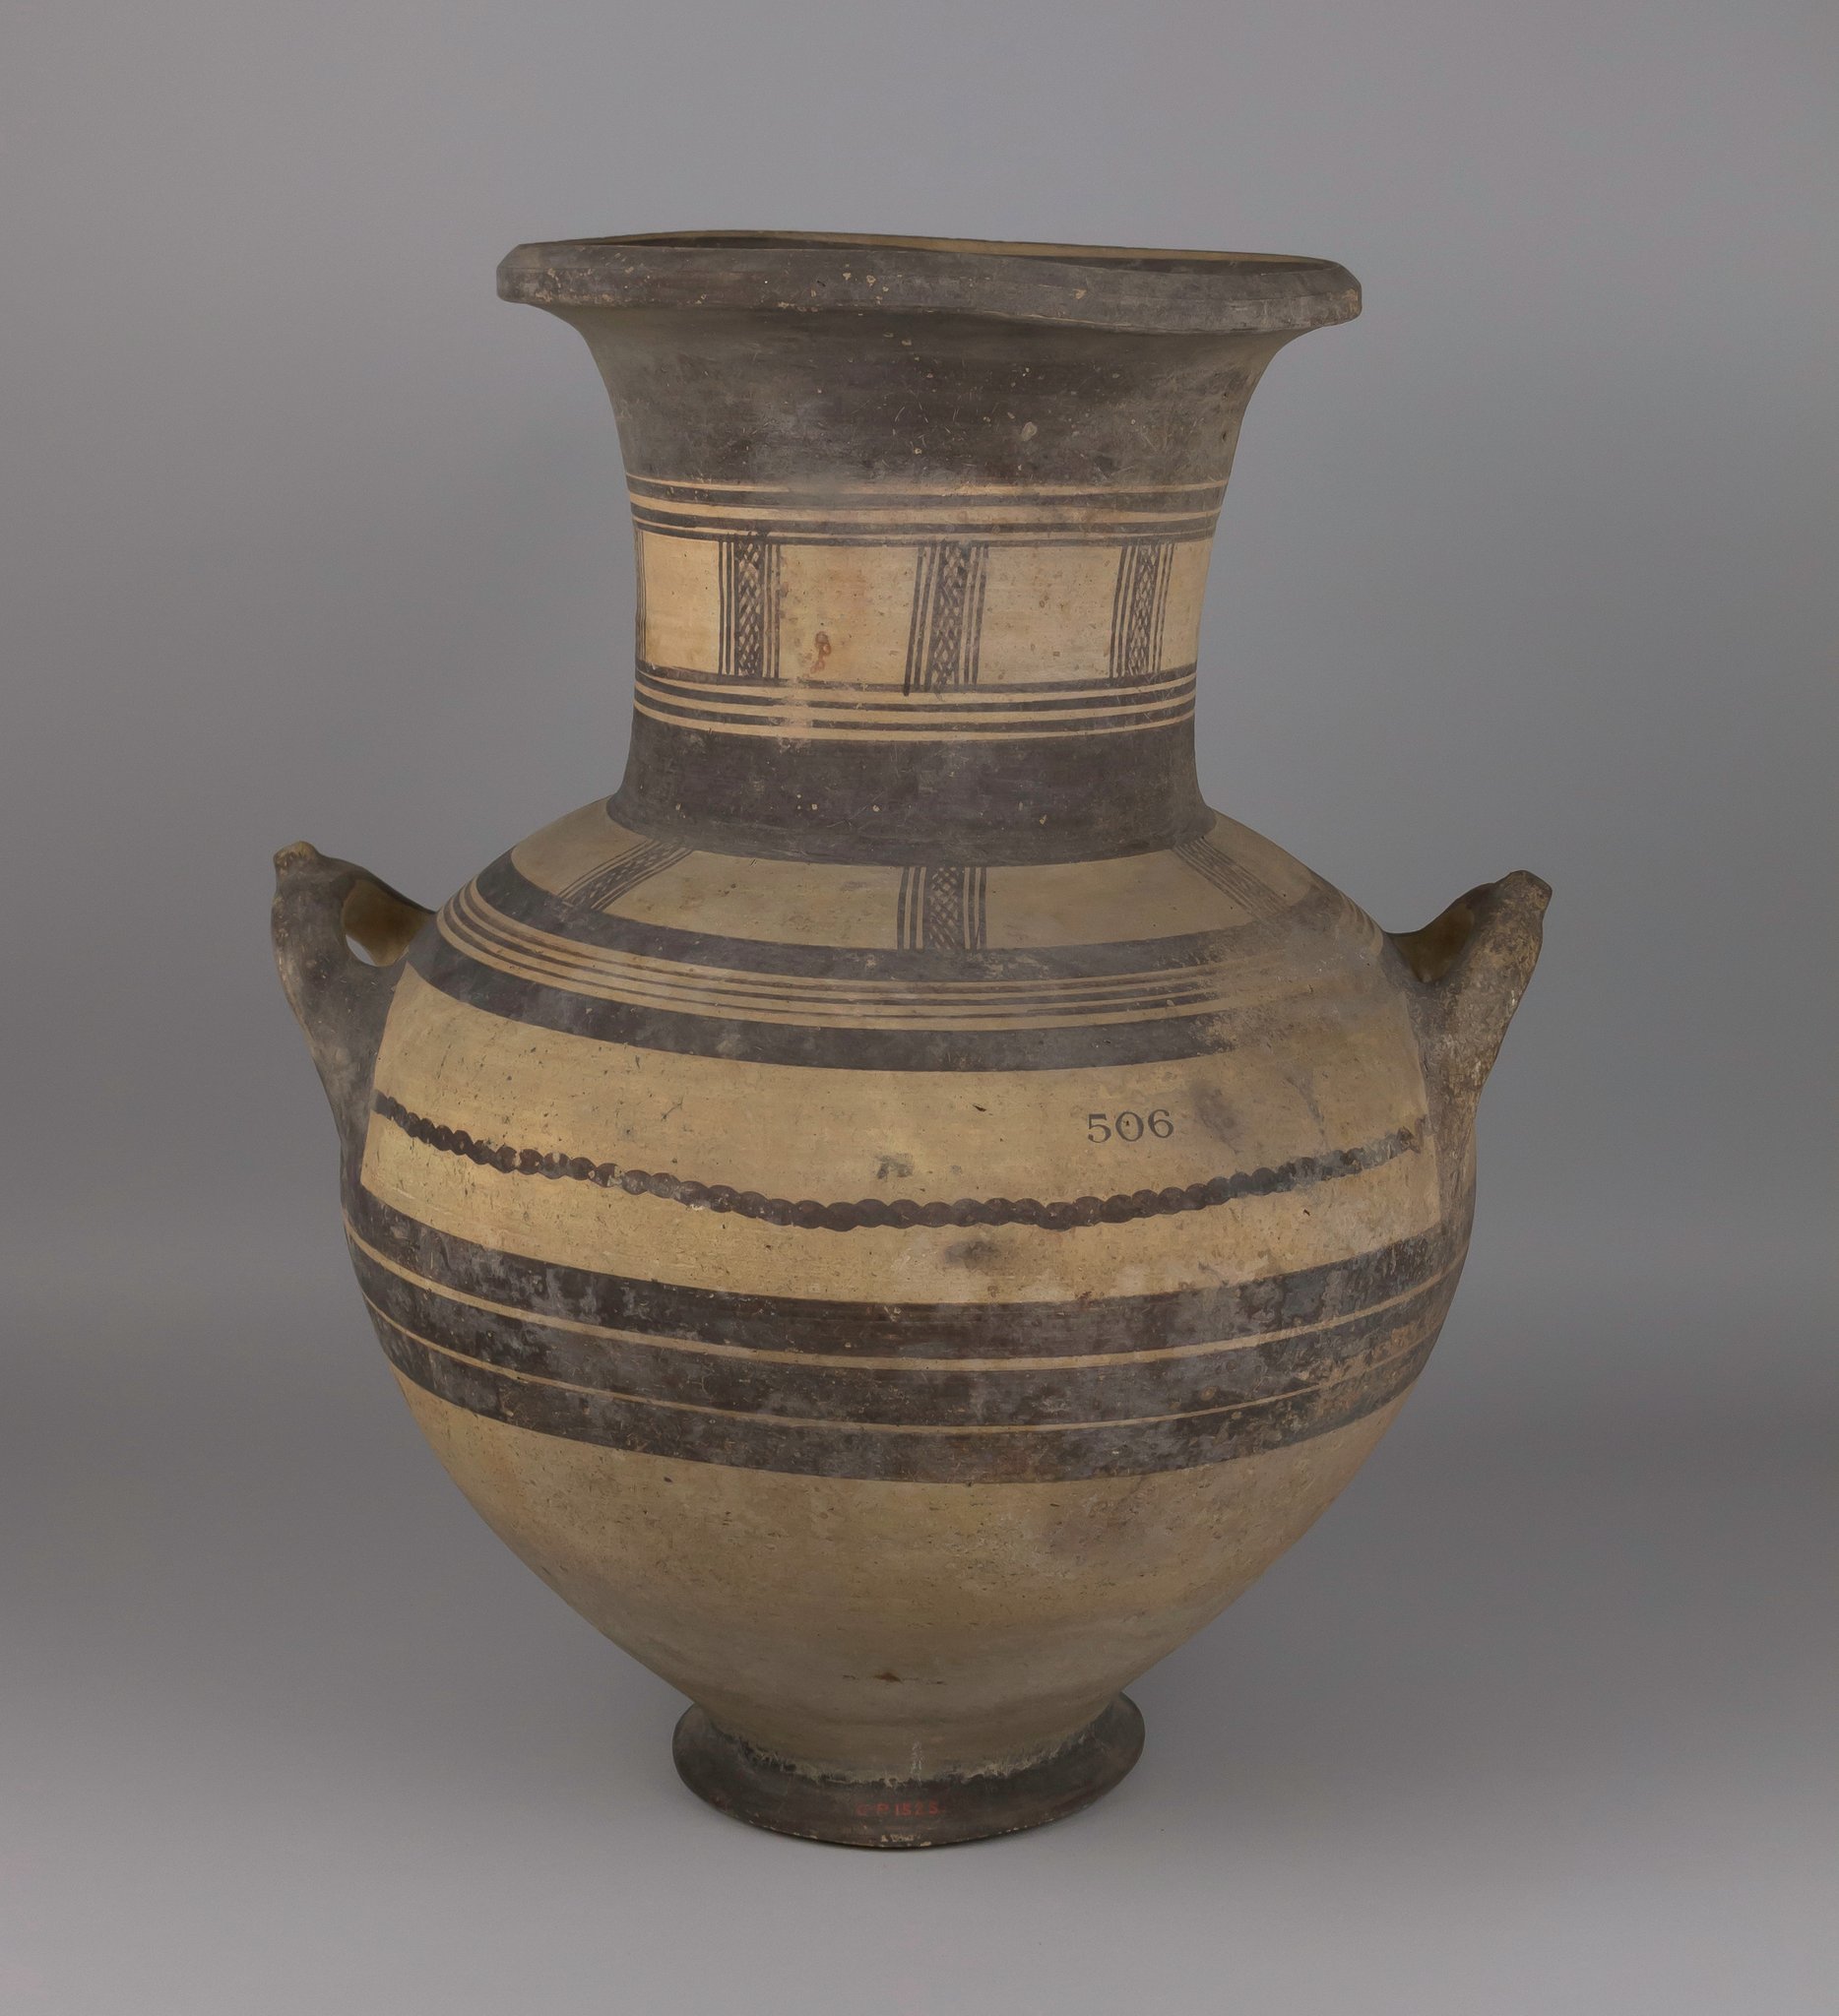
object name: amphora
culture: cypriot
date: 950-850 BCE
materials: terracotta